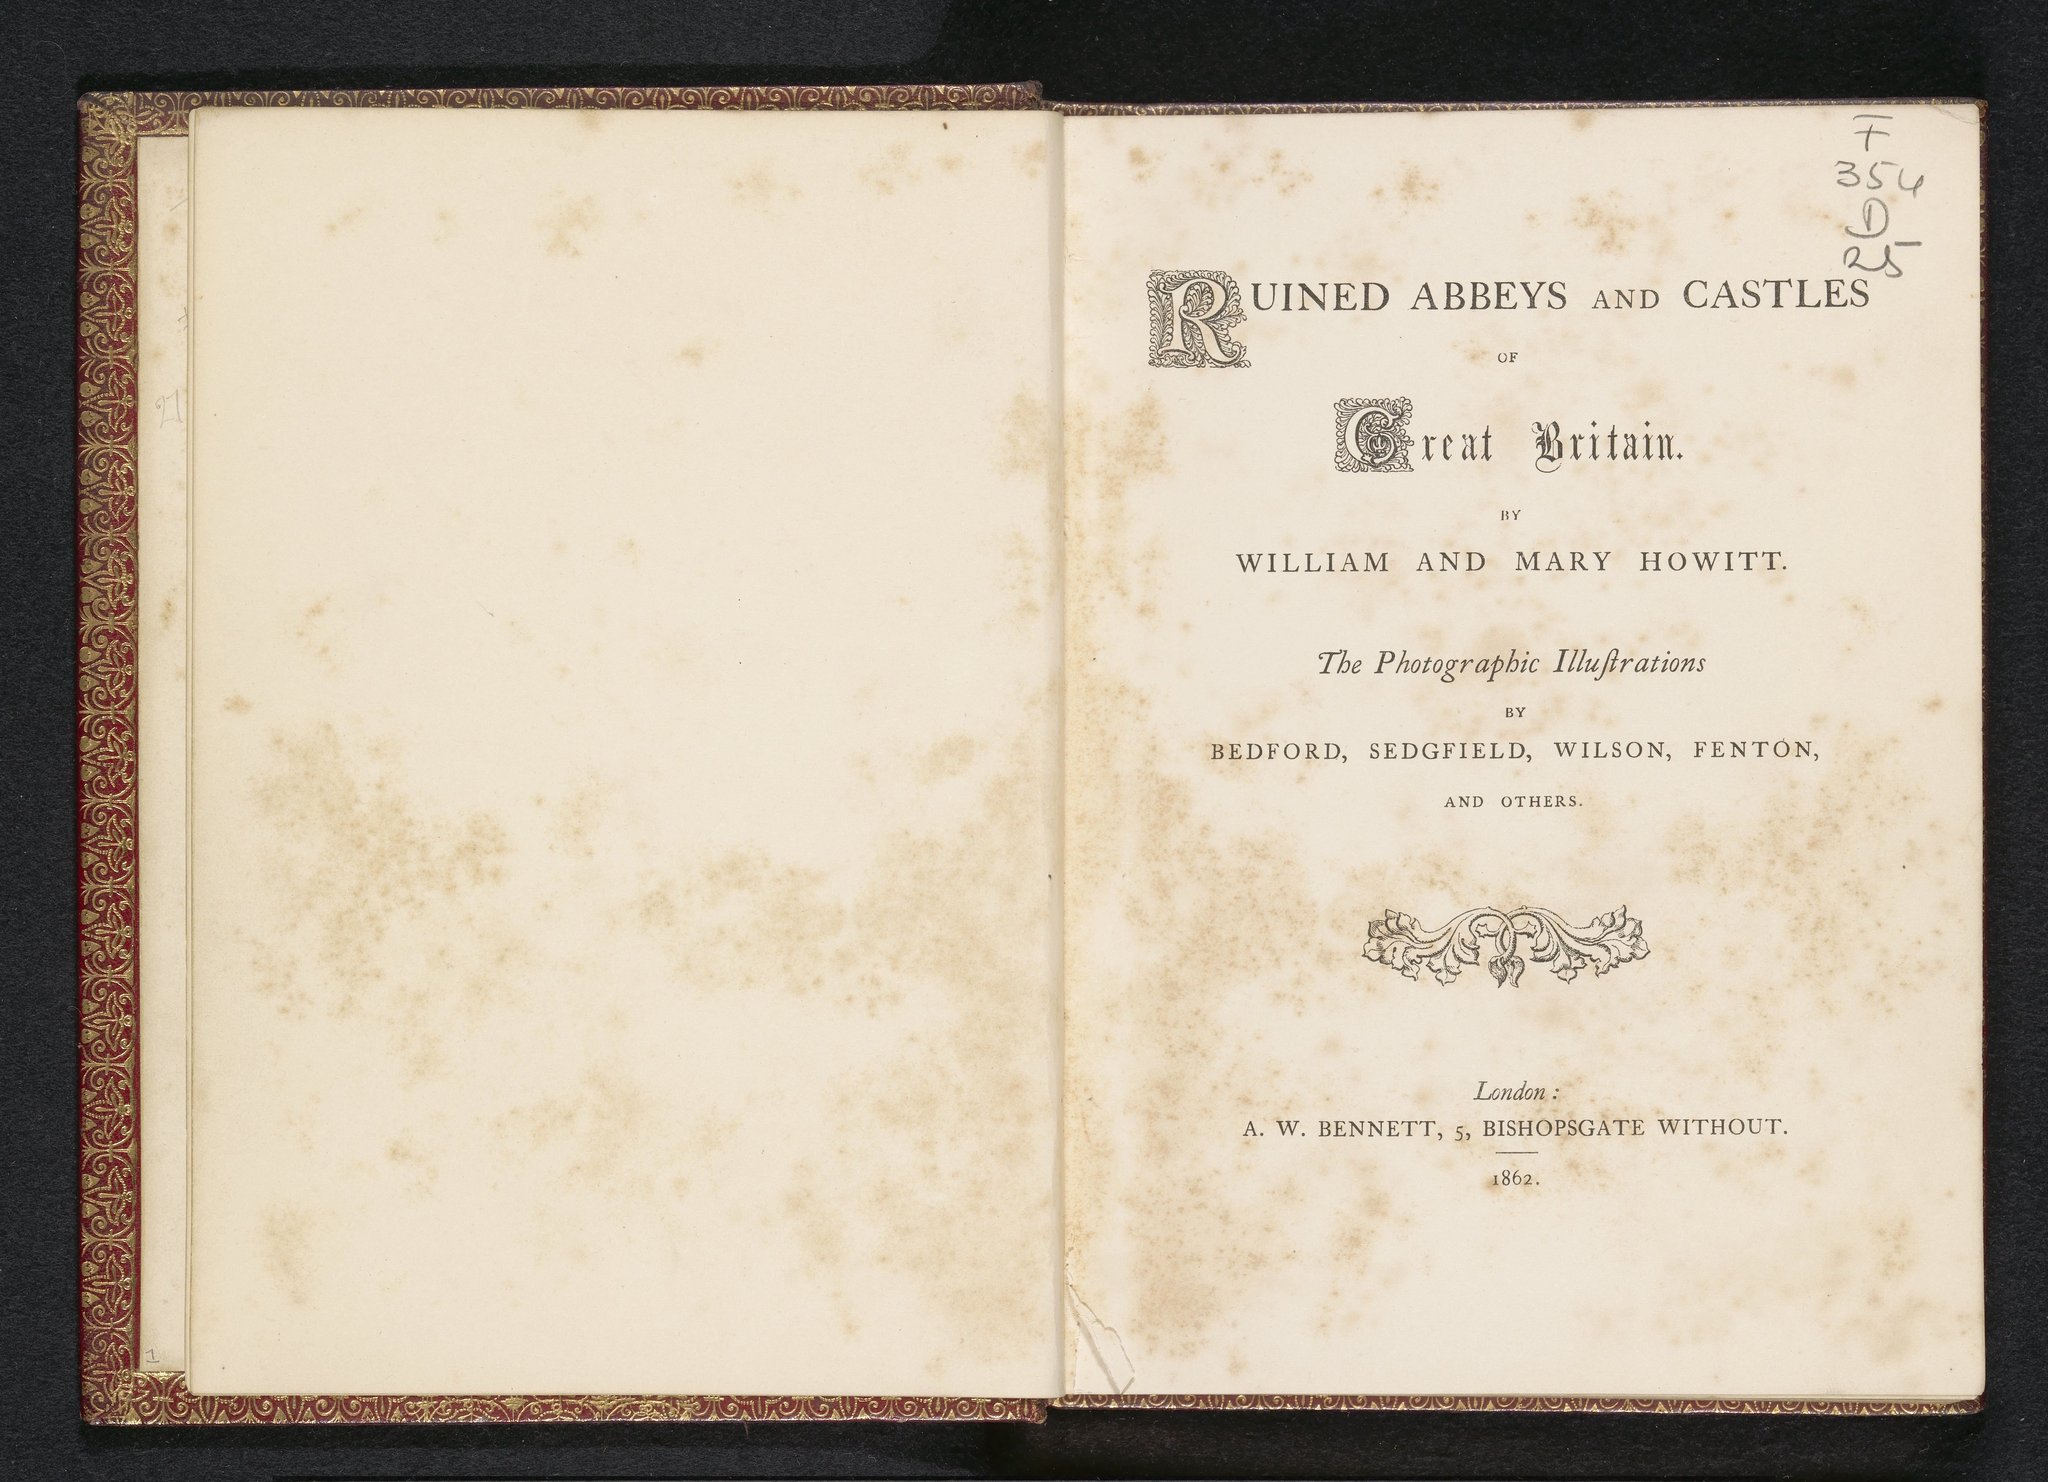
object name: book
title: Ruined abbeys and castles of Great Britain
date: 1862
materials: leather, paper, photographic support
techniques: albumen print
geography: london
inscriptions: name: ‘ex libris SFJ’